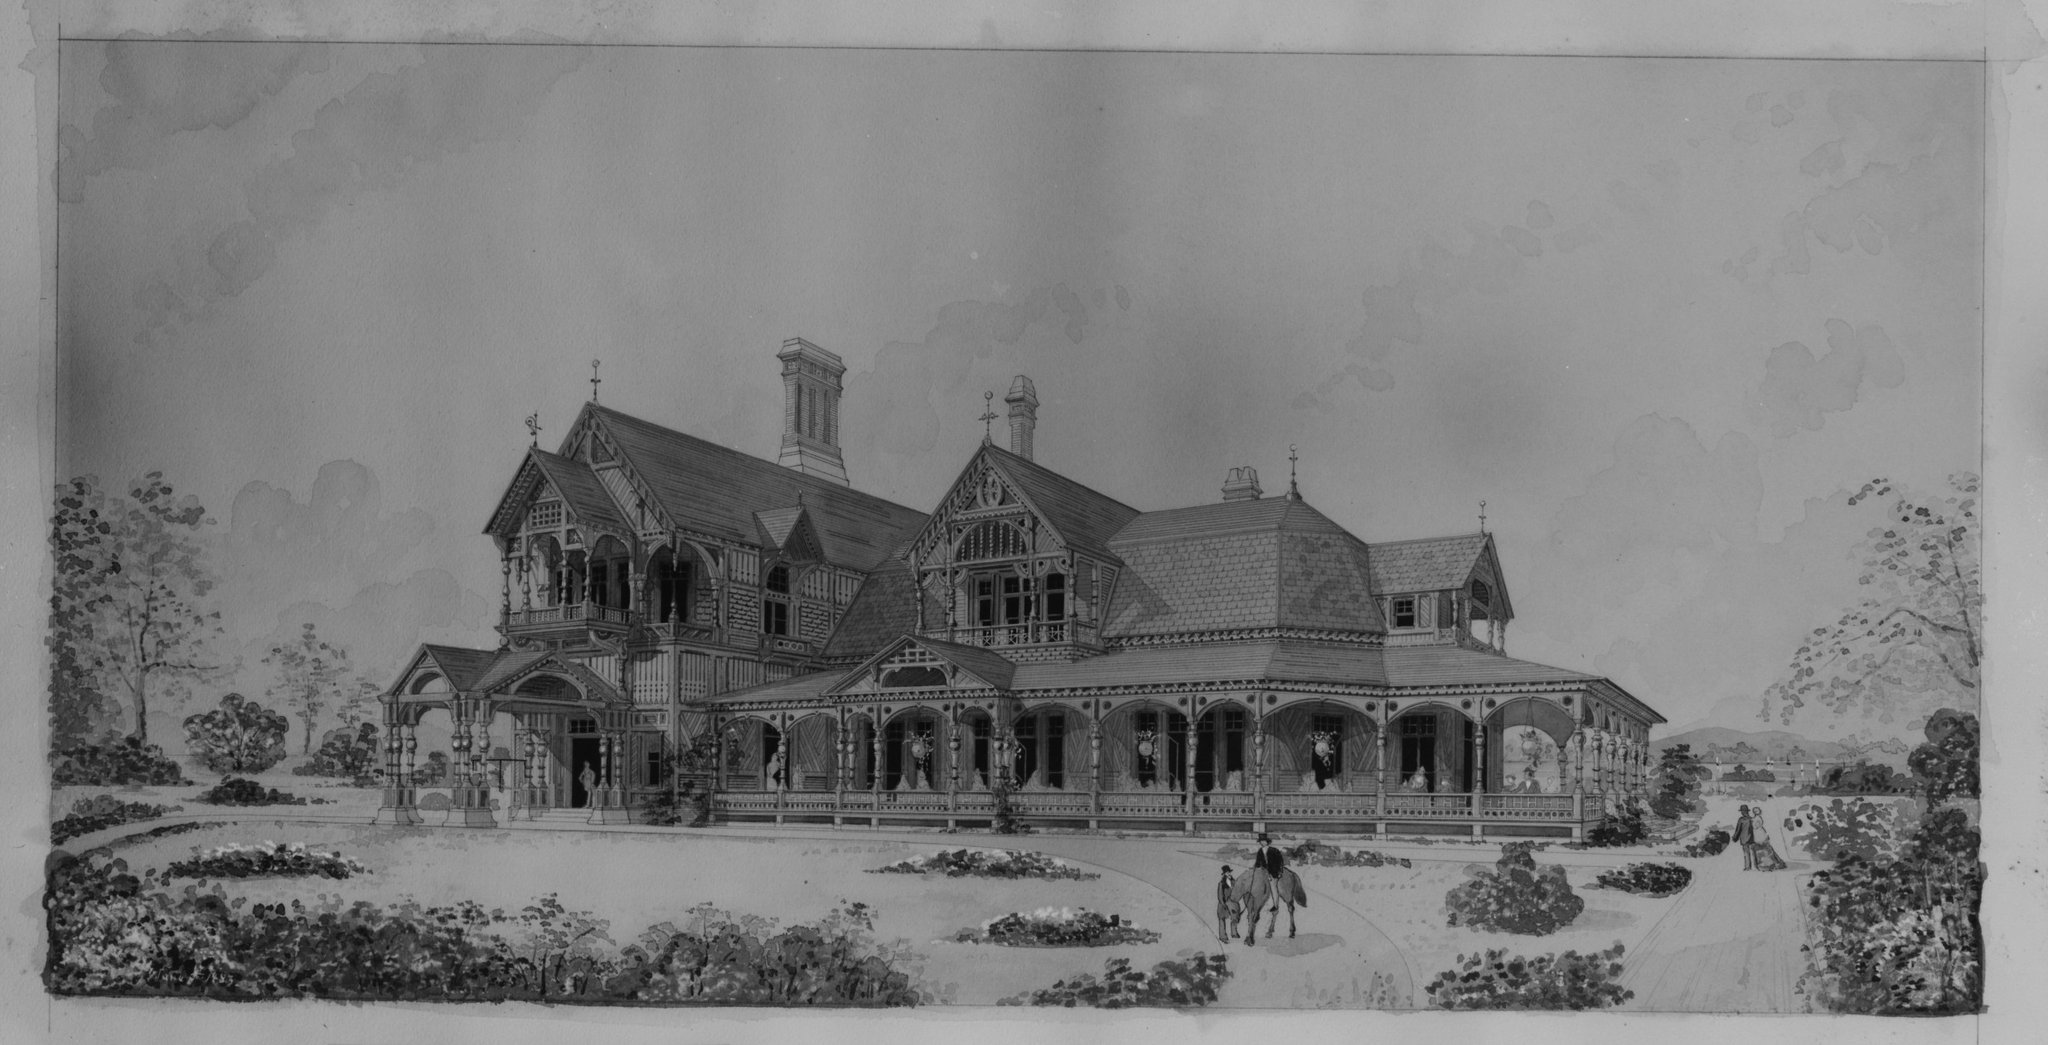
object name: drawing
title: McGowan's Pass Tavern, New York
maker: anonymous, american, 19th century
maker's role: artist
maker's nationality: american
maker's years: 1800-1900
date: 1801-1900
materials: watercolor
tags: buildings,men,women,horses